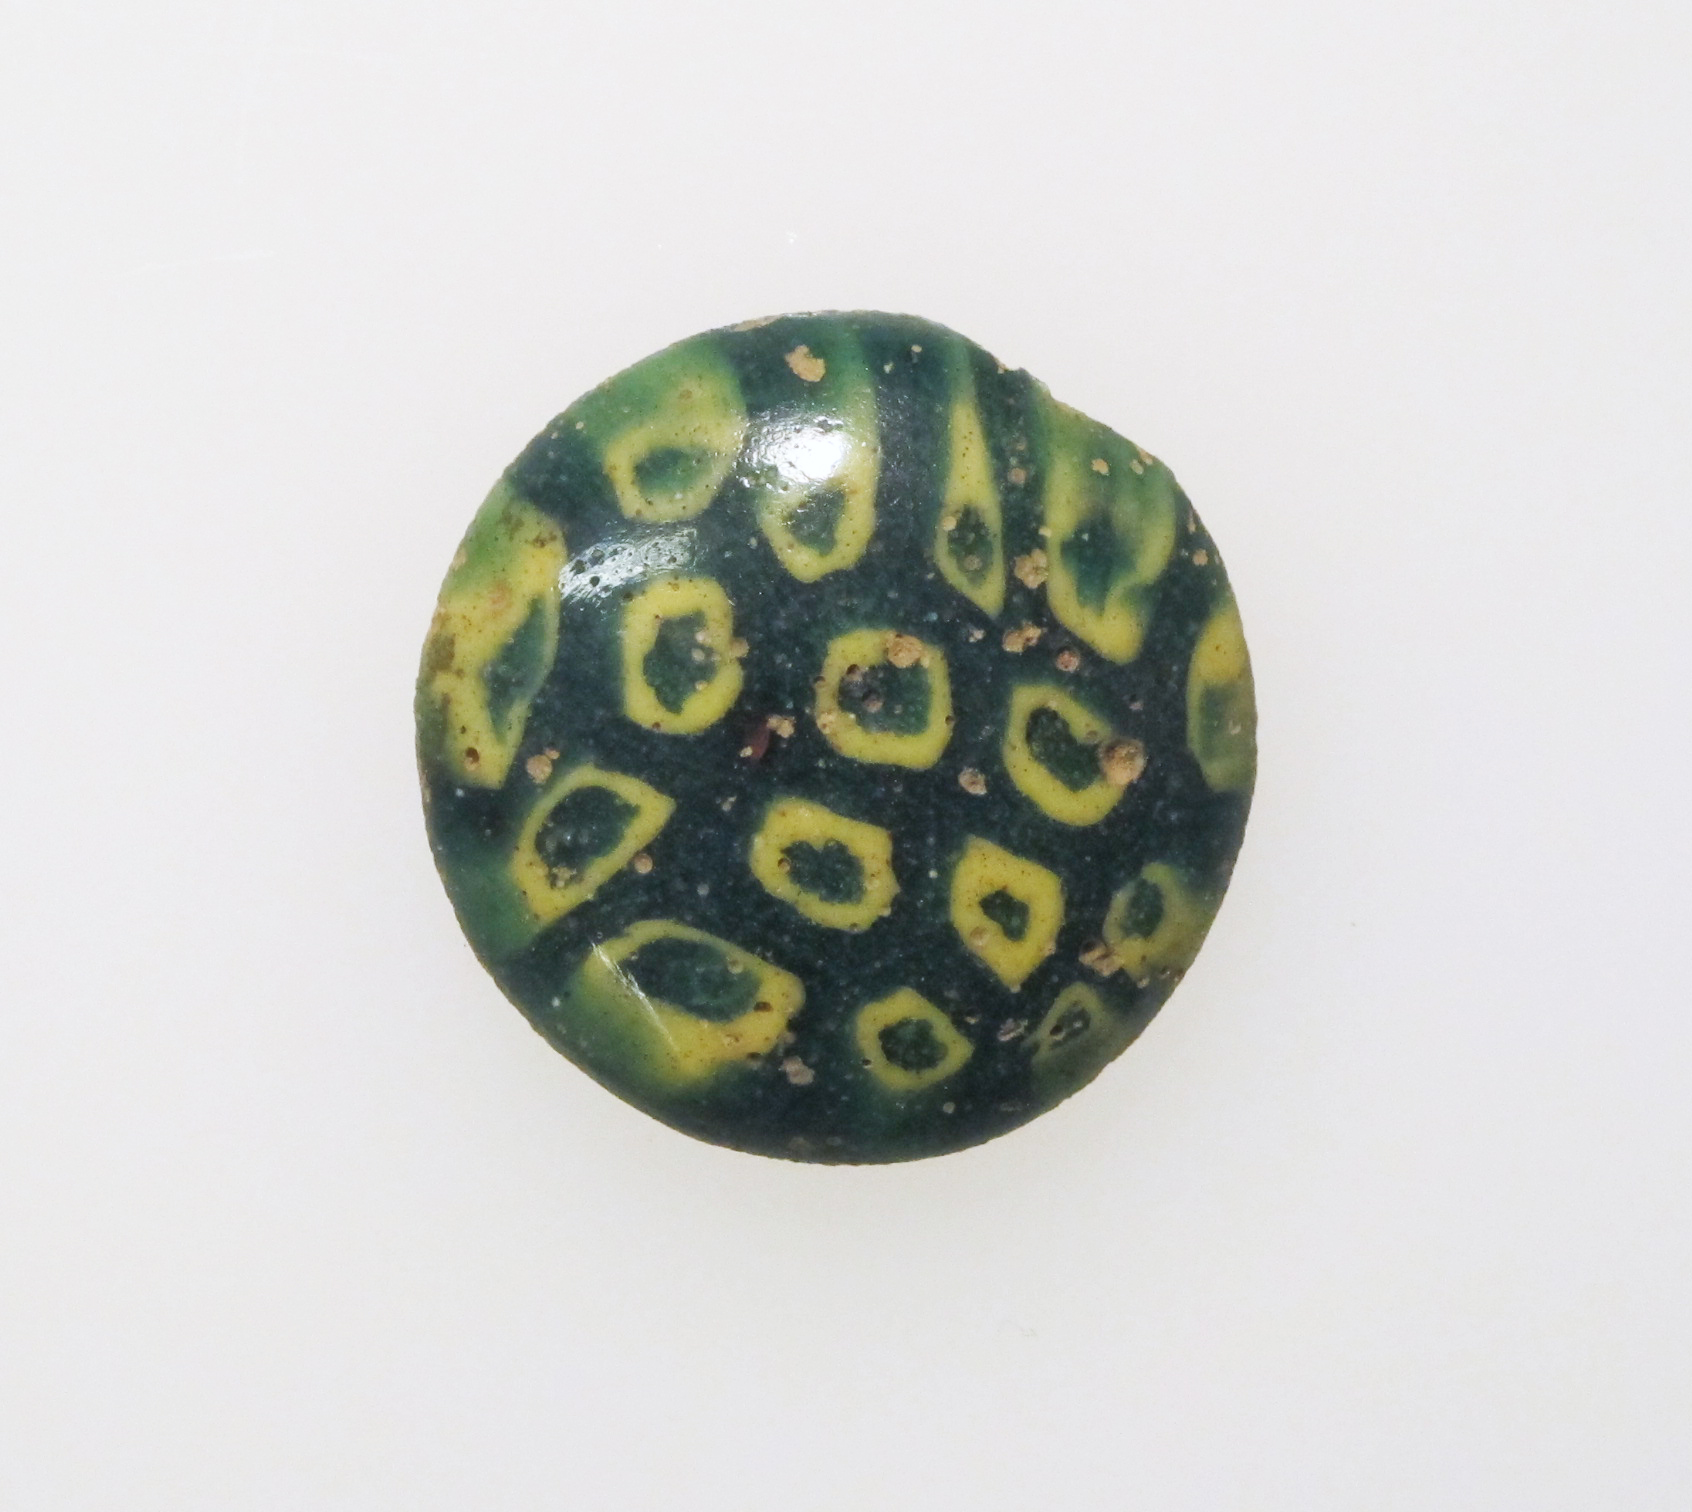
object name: counter or inlay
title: Glass mosaic counter or inlay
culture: roman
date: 201-300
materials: glass